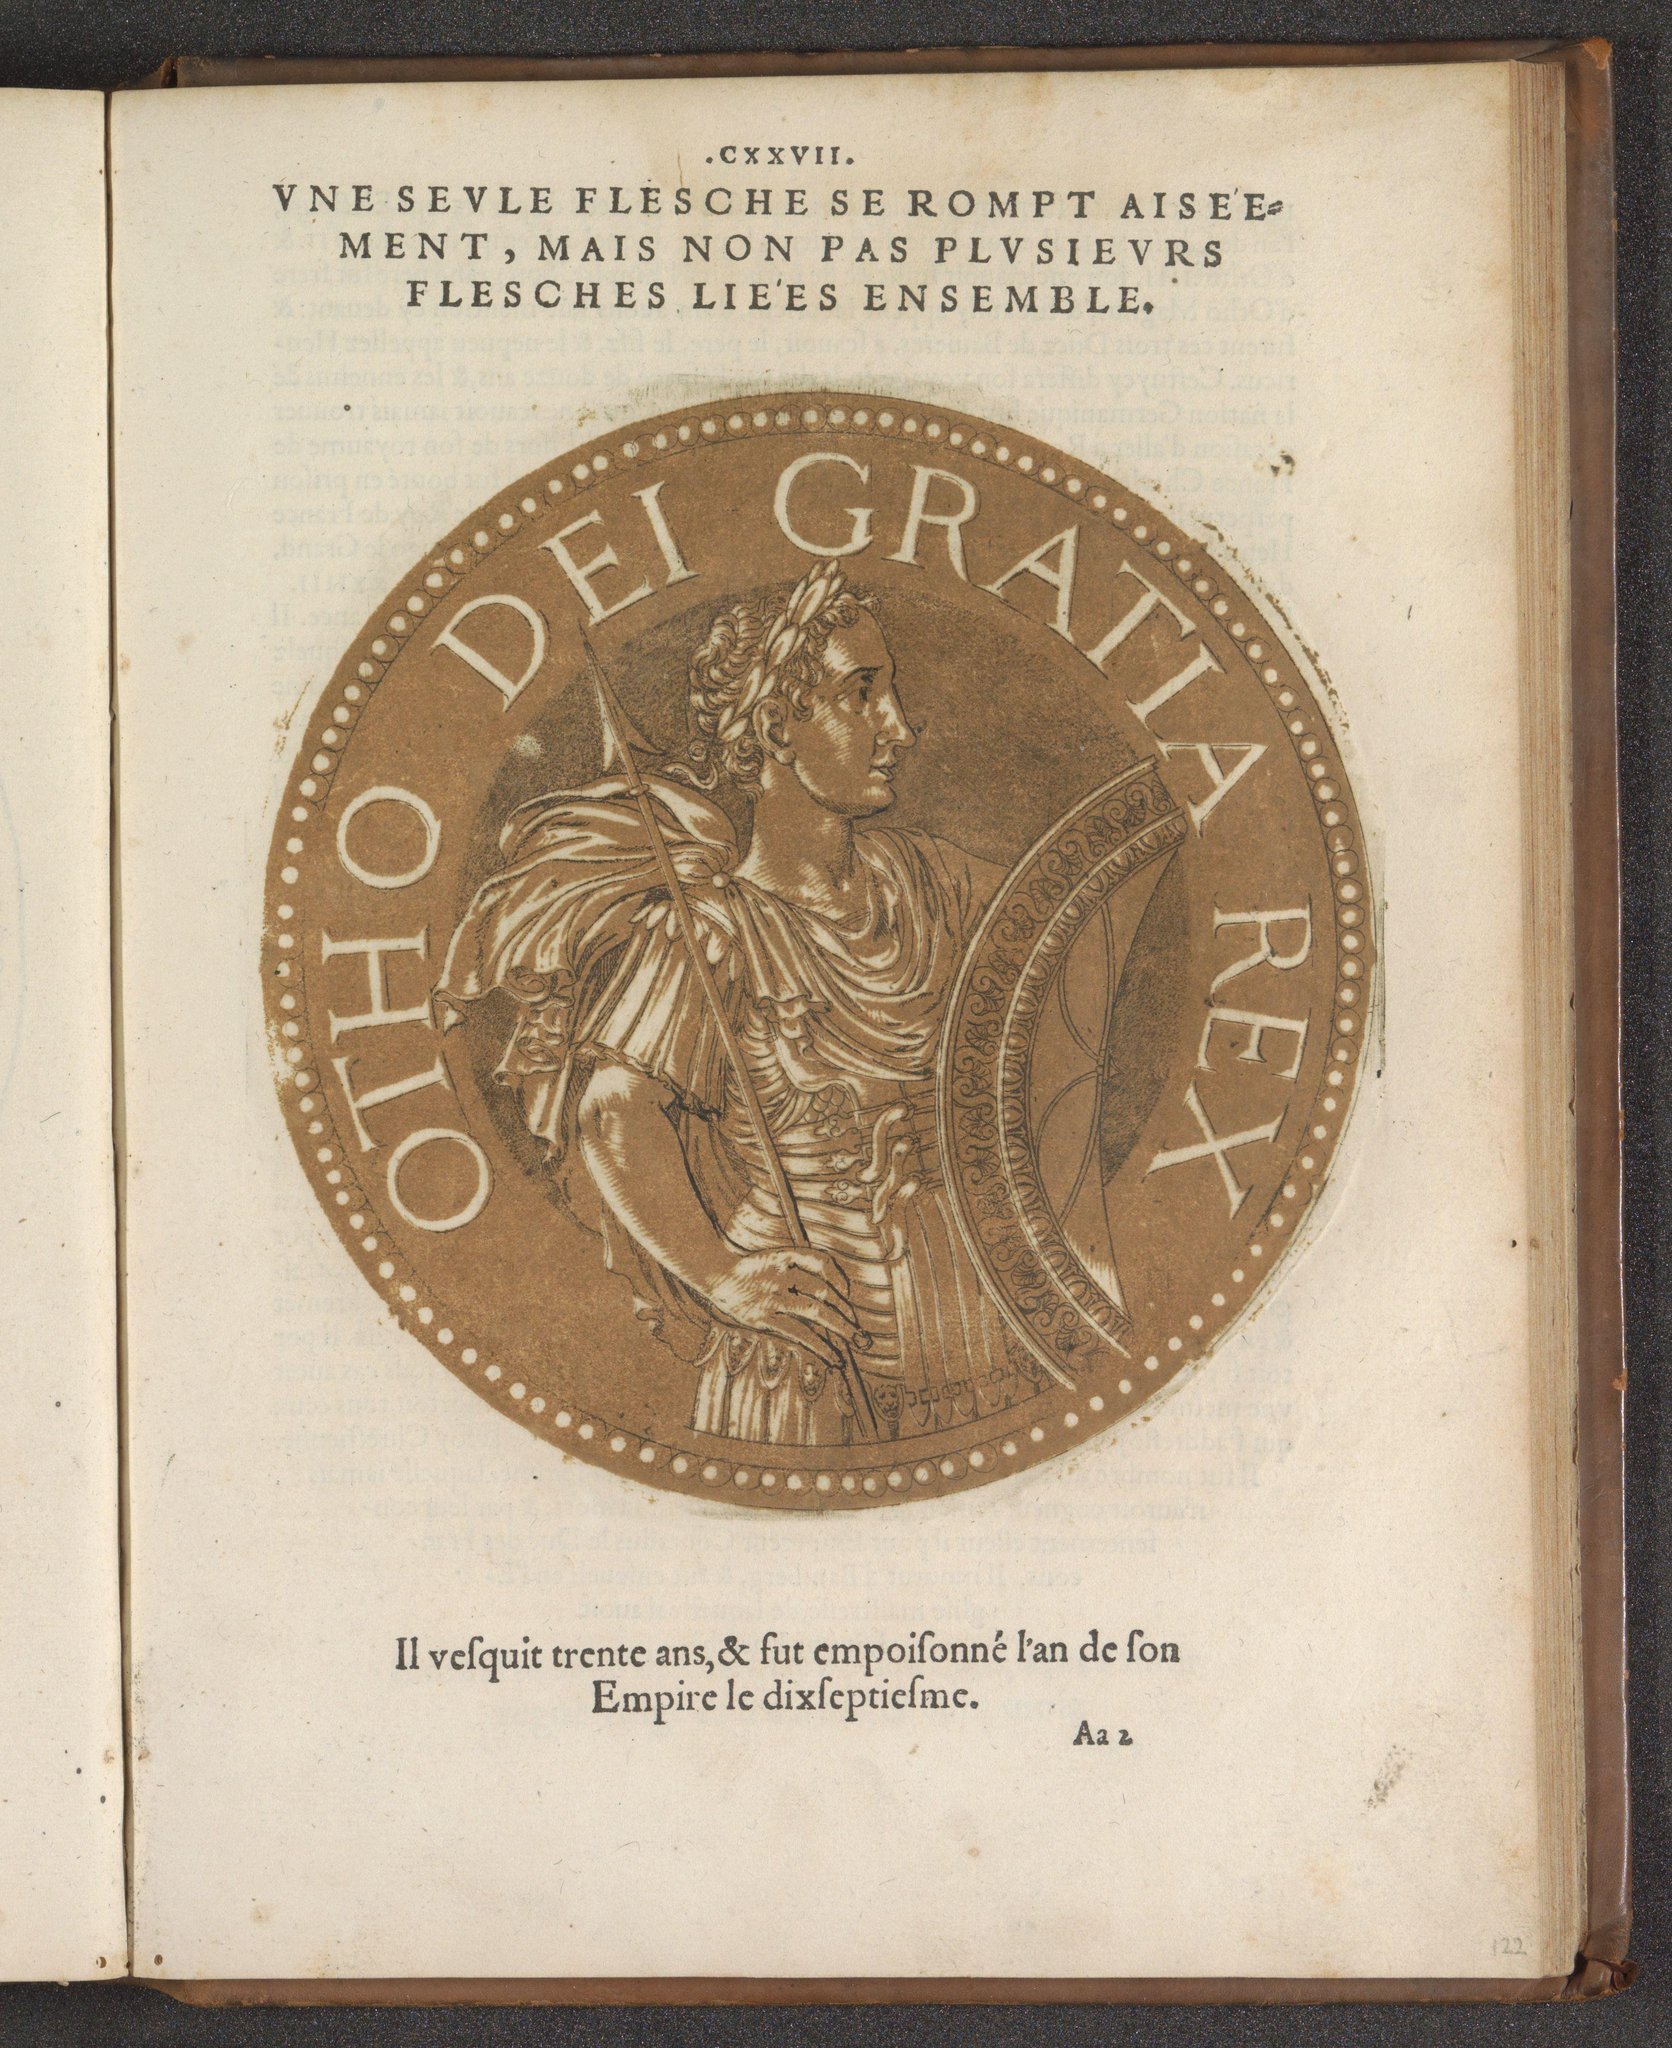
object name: print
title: Les images presque de tous les empereurs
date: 1557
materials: paper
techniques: woodcut, etching, letterpress printing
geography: antwerp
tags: emperor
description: Portret van keizer Otto III, op een munt met randschrift. De prent maakt deel uit van een boek over de keizers vanaf Julius Caesar tot en met Karel V en zijn broer Ferdinand.